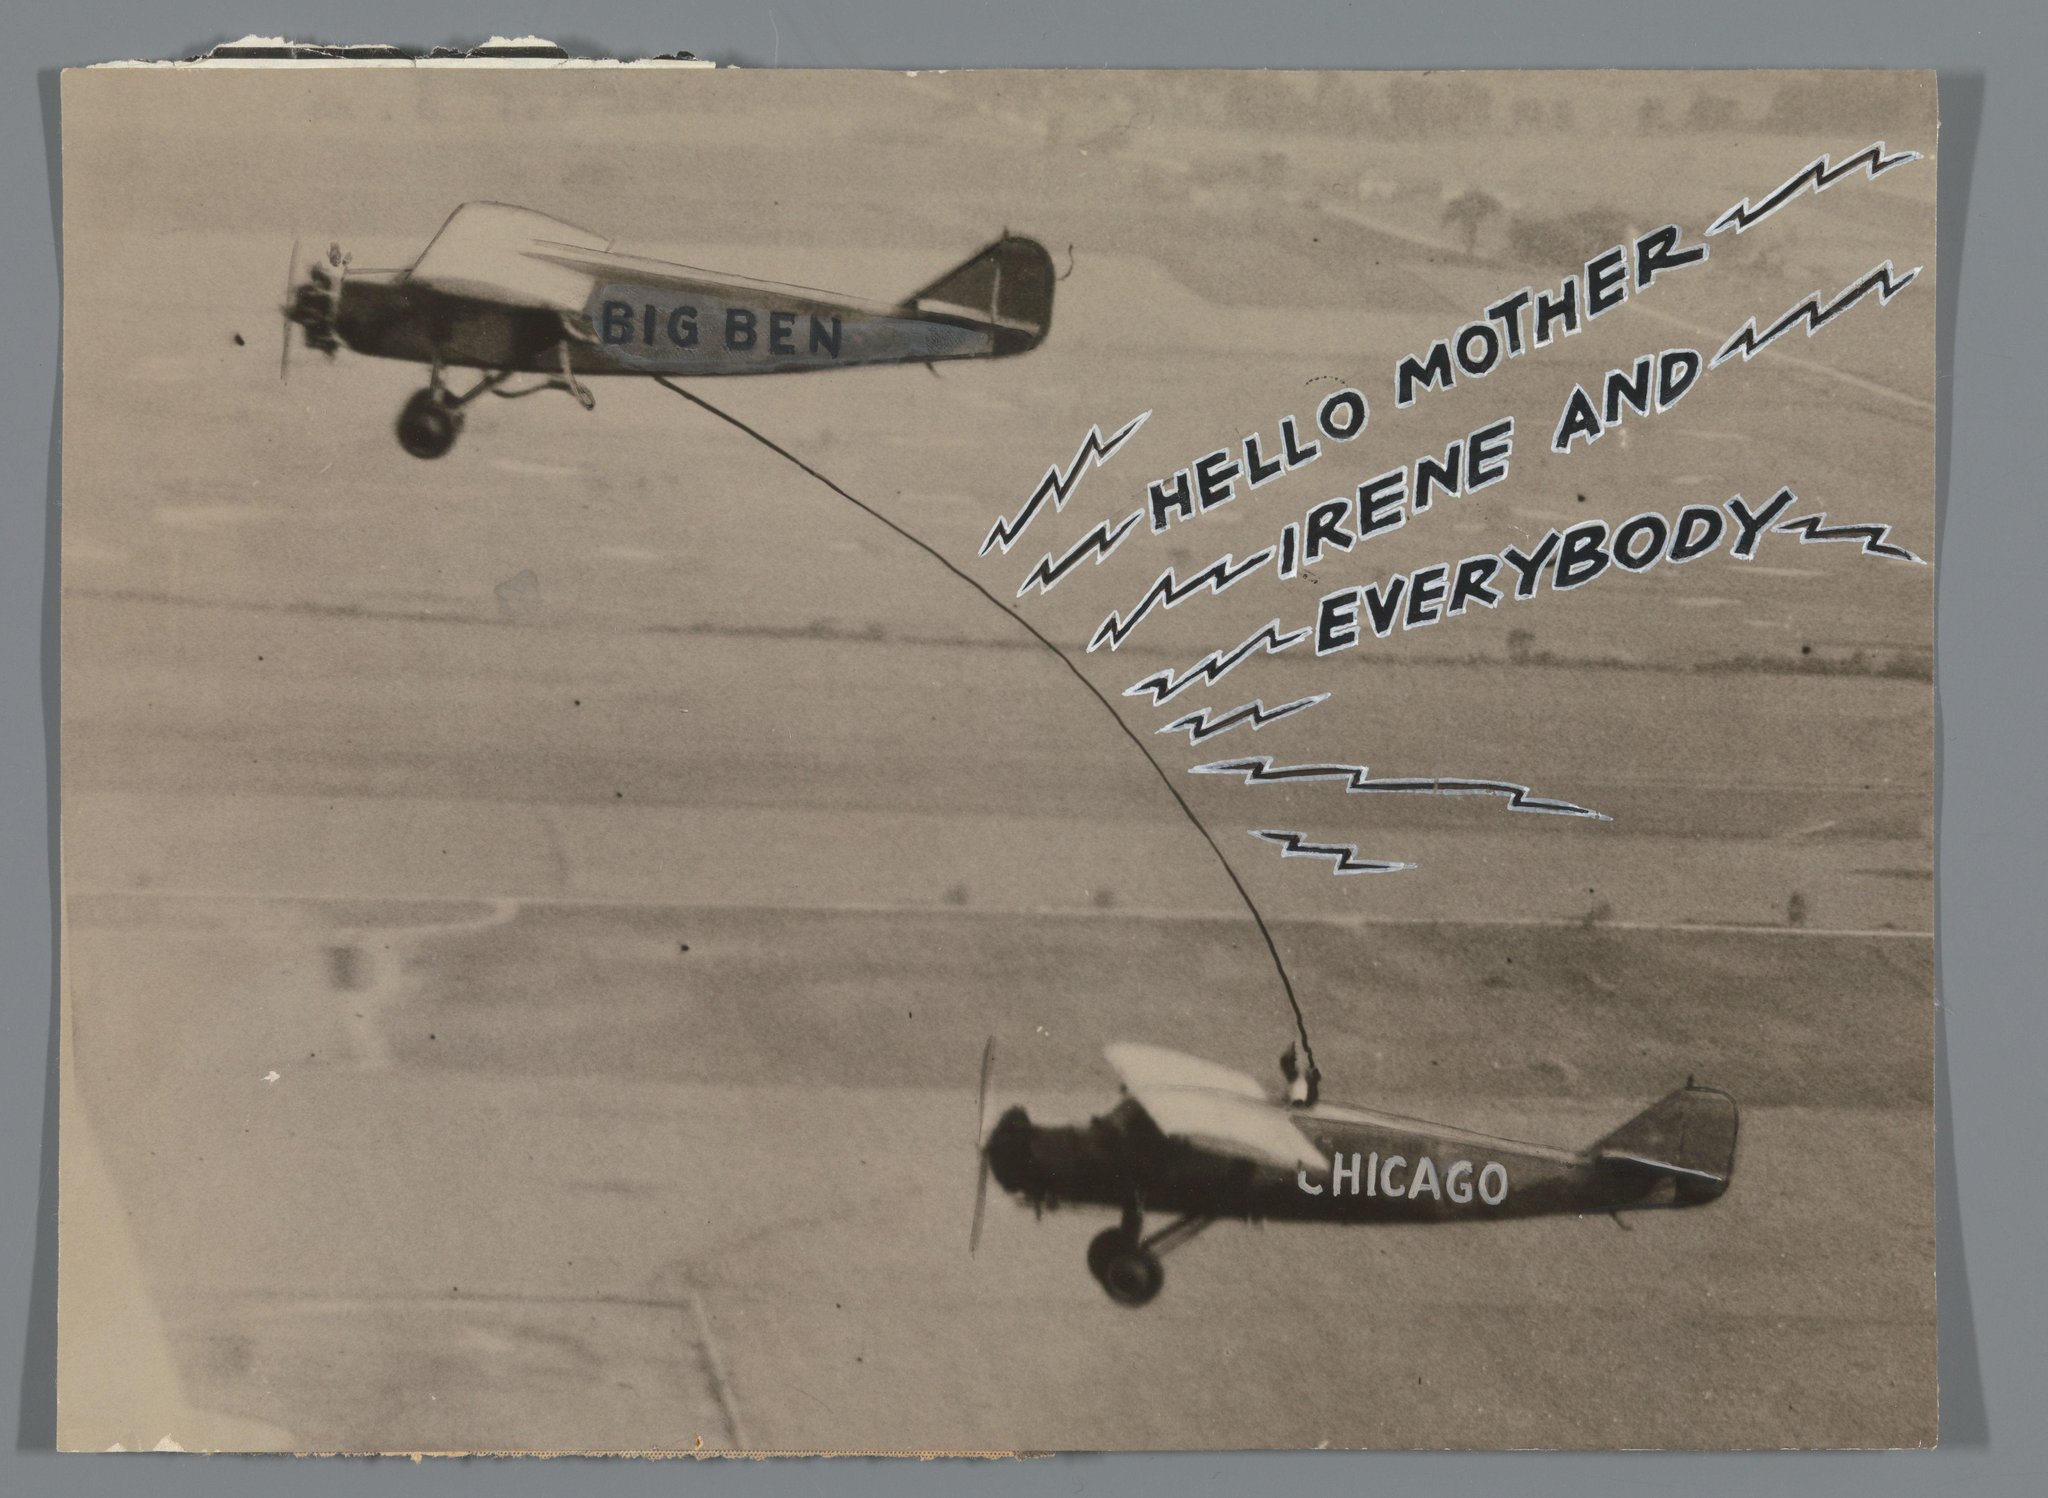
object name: photograph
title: Persfoto Hunter brothers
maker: Anonymous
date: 1930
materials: paper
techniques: gelatin silver print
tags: aircraft, aeroplane, electrical and electronic means of (tele)communication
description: Persfoto voorzien van handgeschreven tekst en met aanwijzingen voor de opmaker.